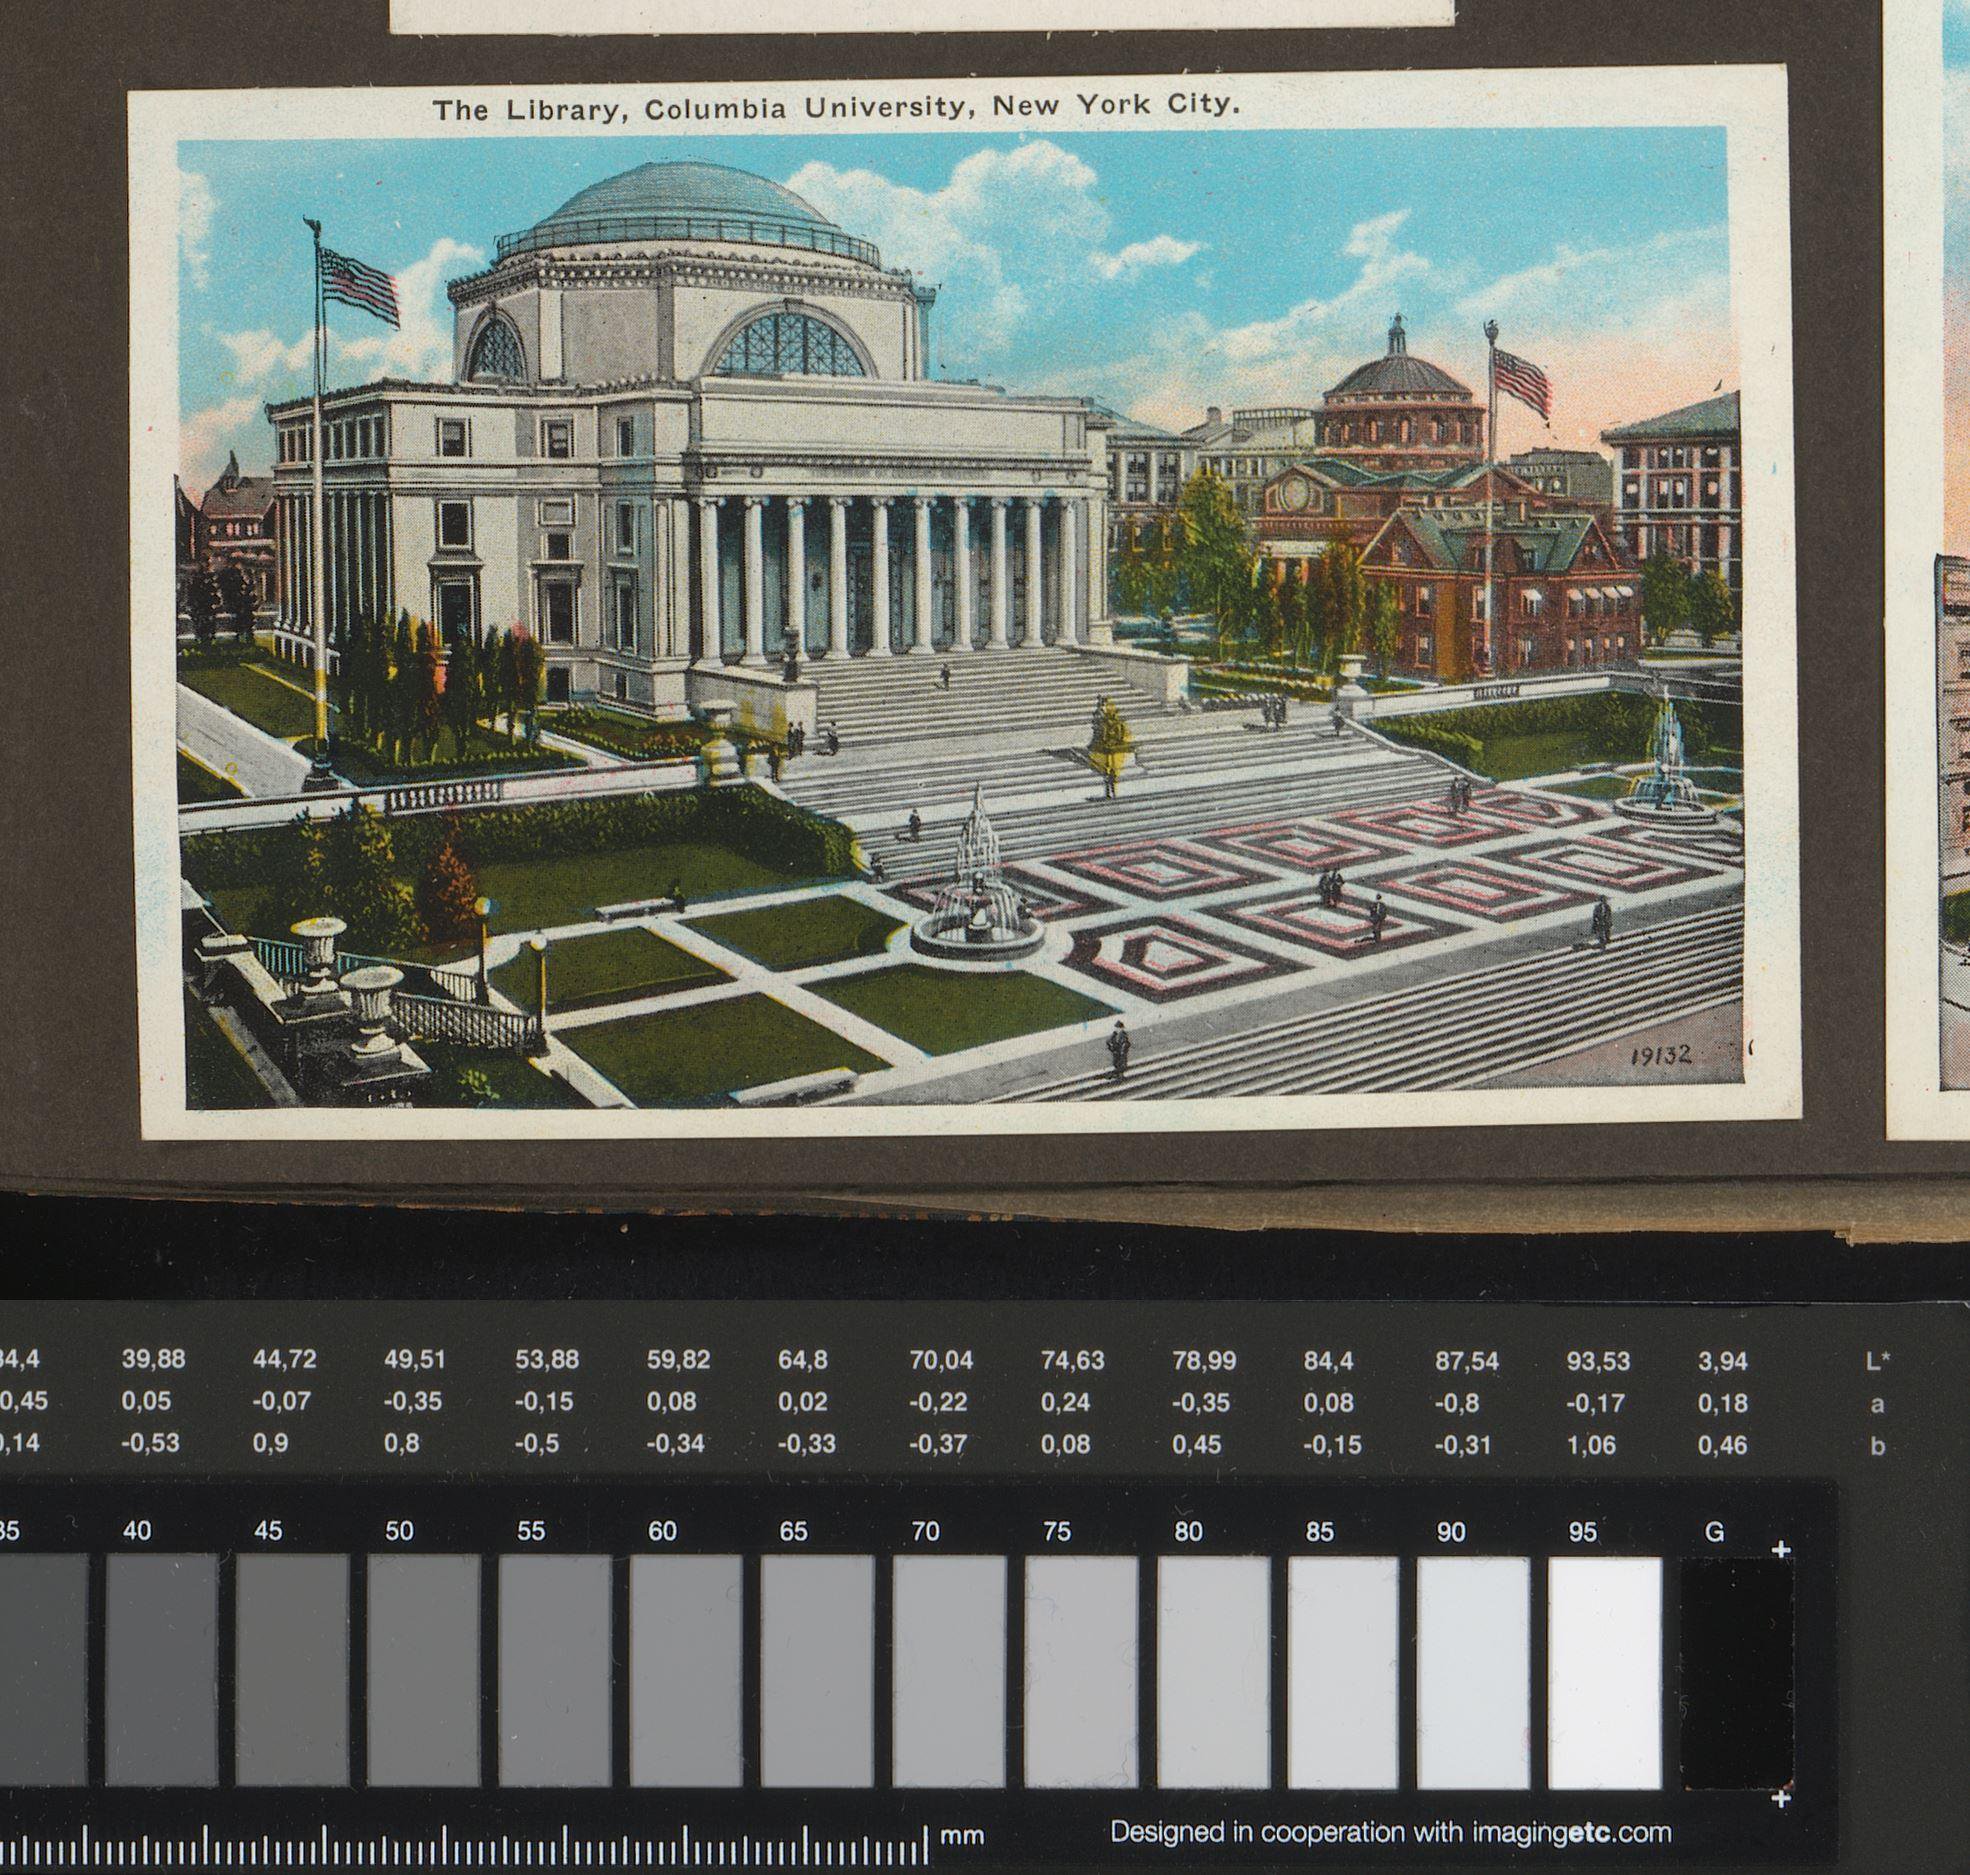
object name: album leaf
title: The library, Columbia University, New York City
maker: Anonymous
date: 1928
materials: paper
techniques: four-color autotype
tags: civic architecture; edifices; dwellings, public library, new york (city)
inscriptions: number: ‘19132’